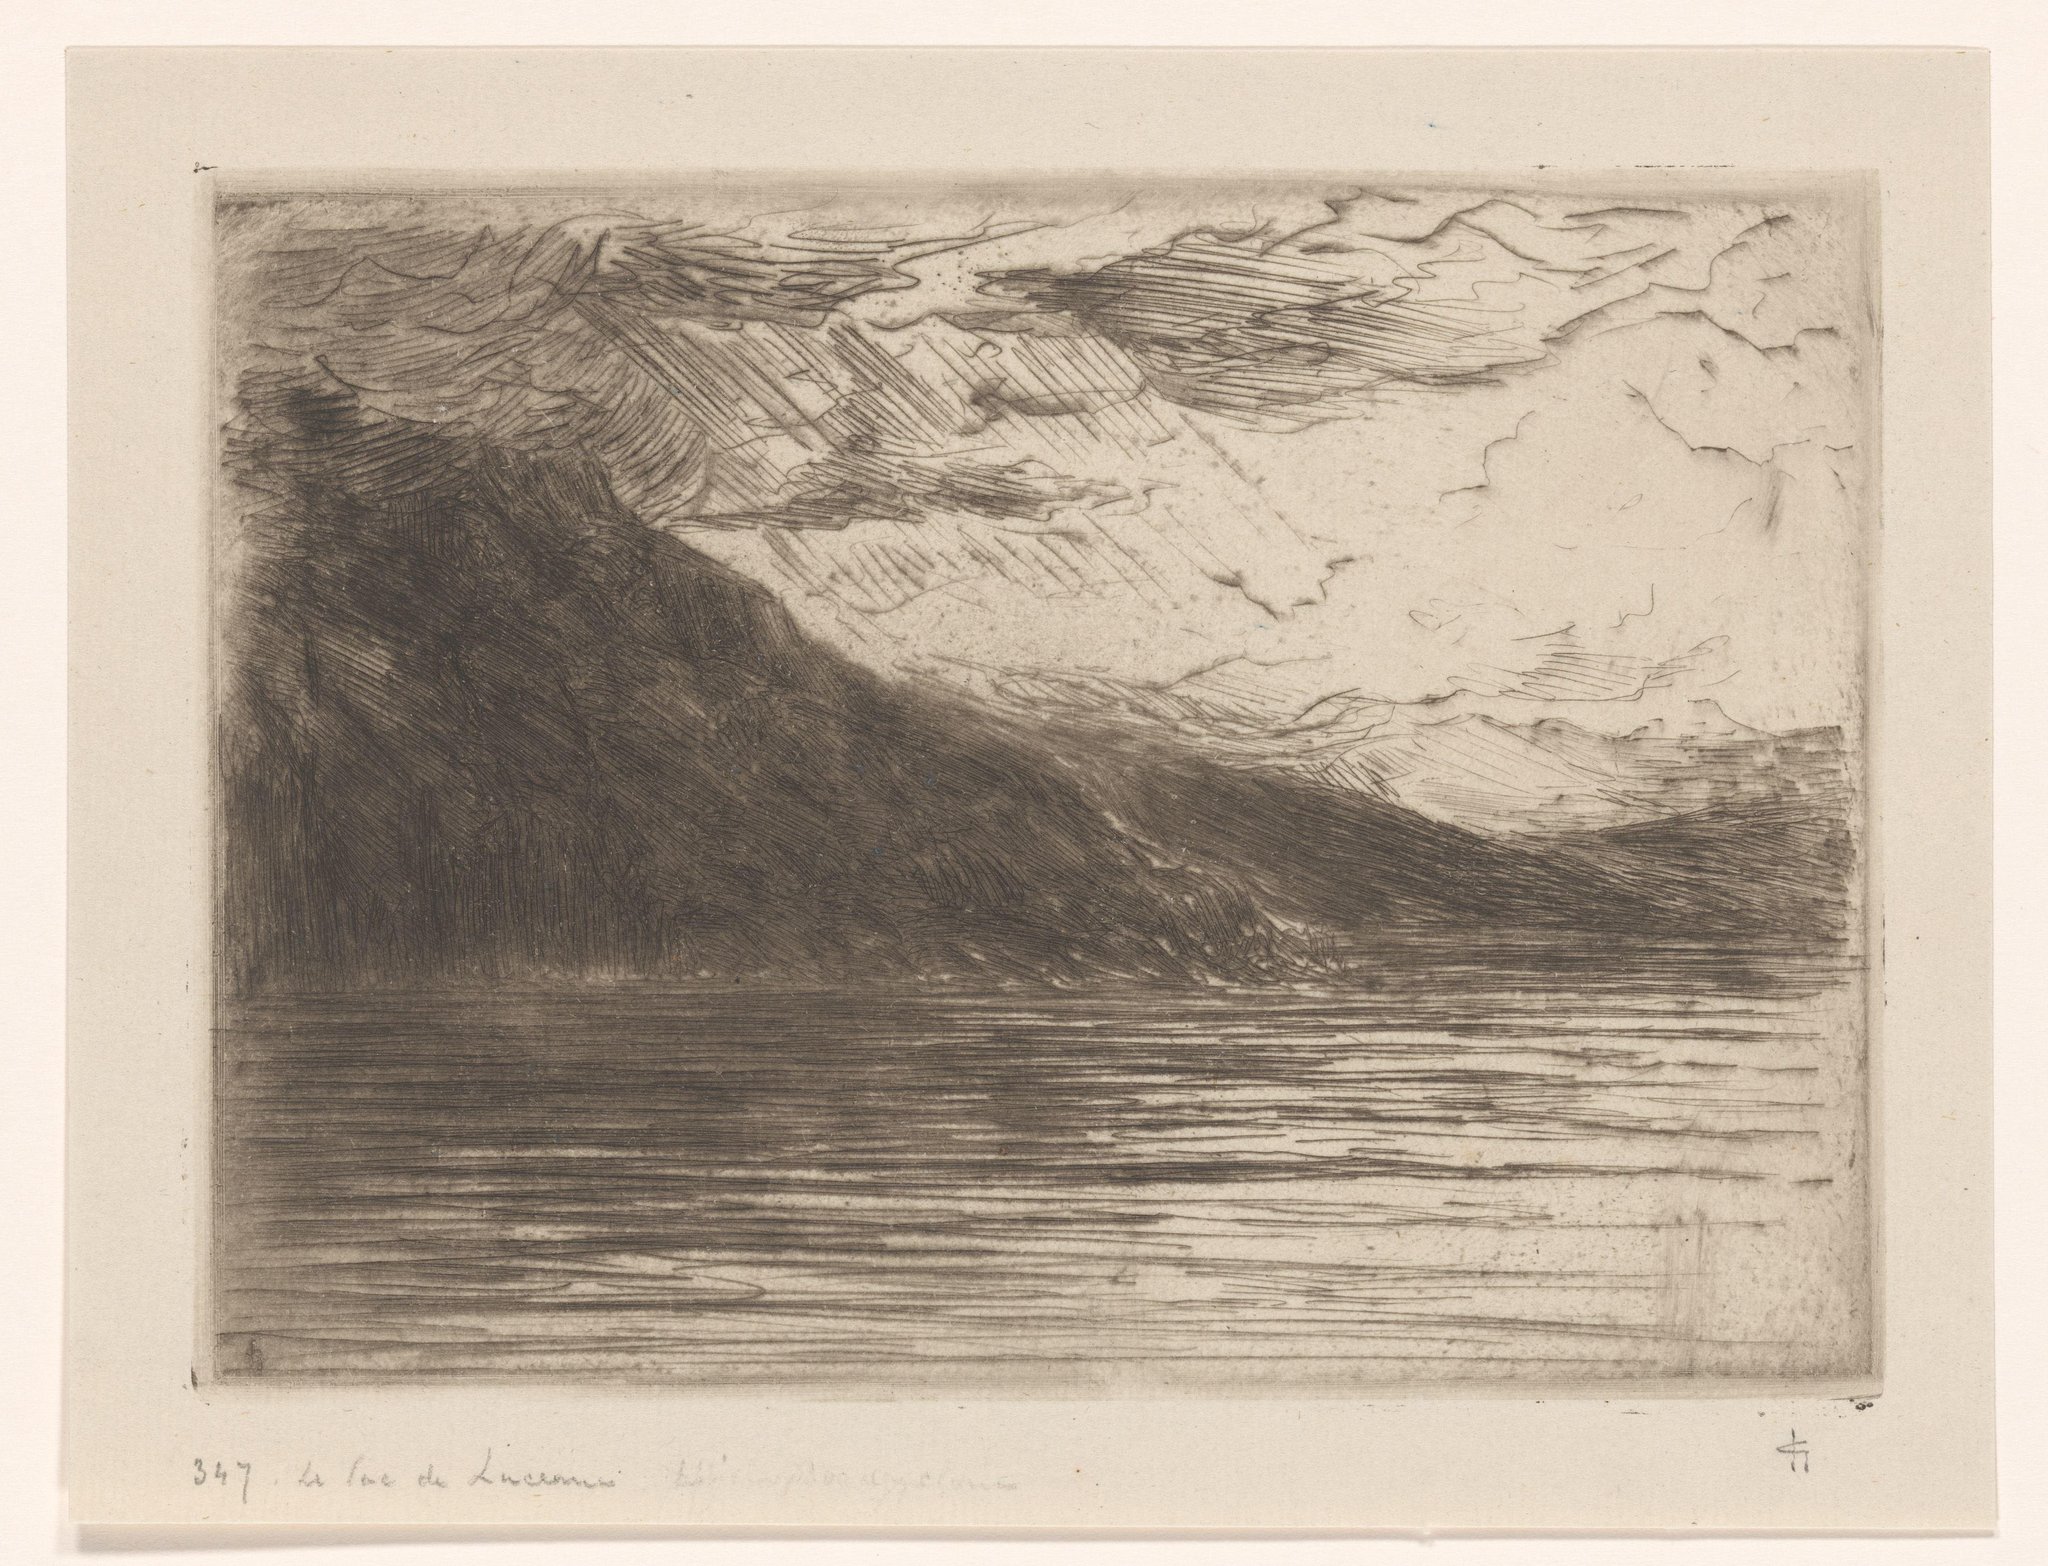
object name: print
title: La lac du Lucerne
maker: carel nicolaas storm van s-gravesande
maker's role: draughtsman, print maker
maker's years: 1841-1924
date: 1889-1902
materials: paper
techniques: drypoint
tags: lake, storm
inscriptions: collector's mark: Lugt 2228, number: ‘347’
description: Mogelijk vermeld in: Storm van 's-Gravesande, Charles. Catalogue des eaux-fortes et lithographies. New York: s.n., 1903, of in een onbekende latere uitgave van het manuscript. Vermoedelijk vermeld als catalogusnummer 347.